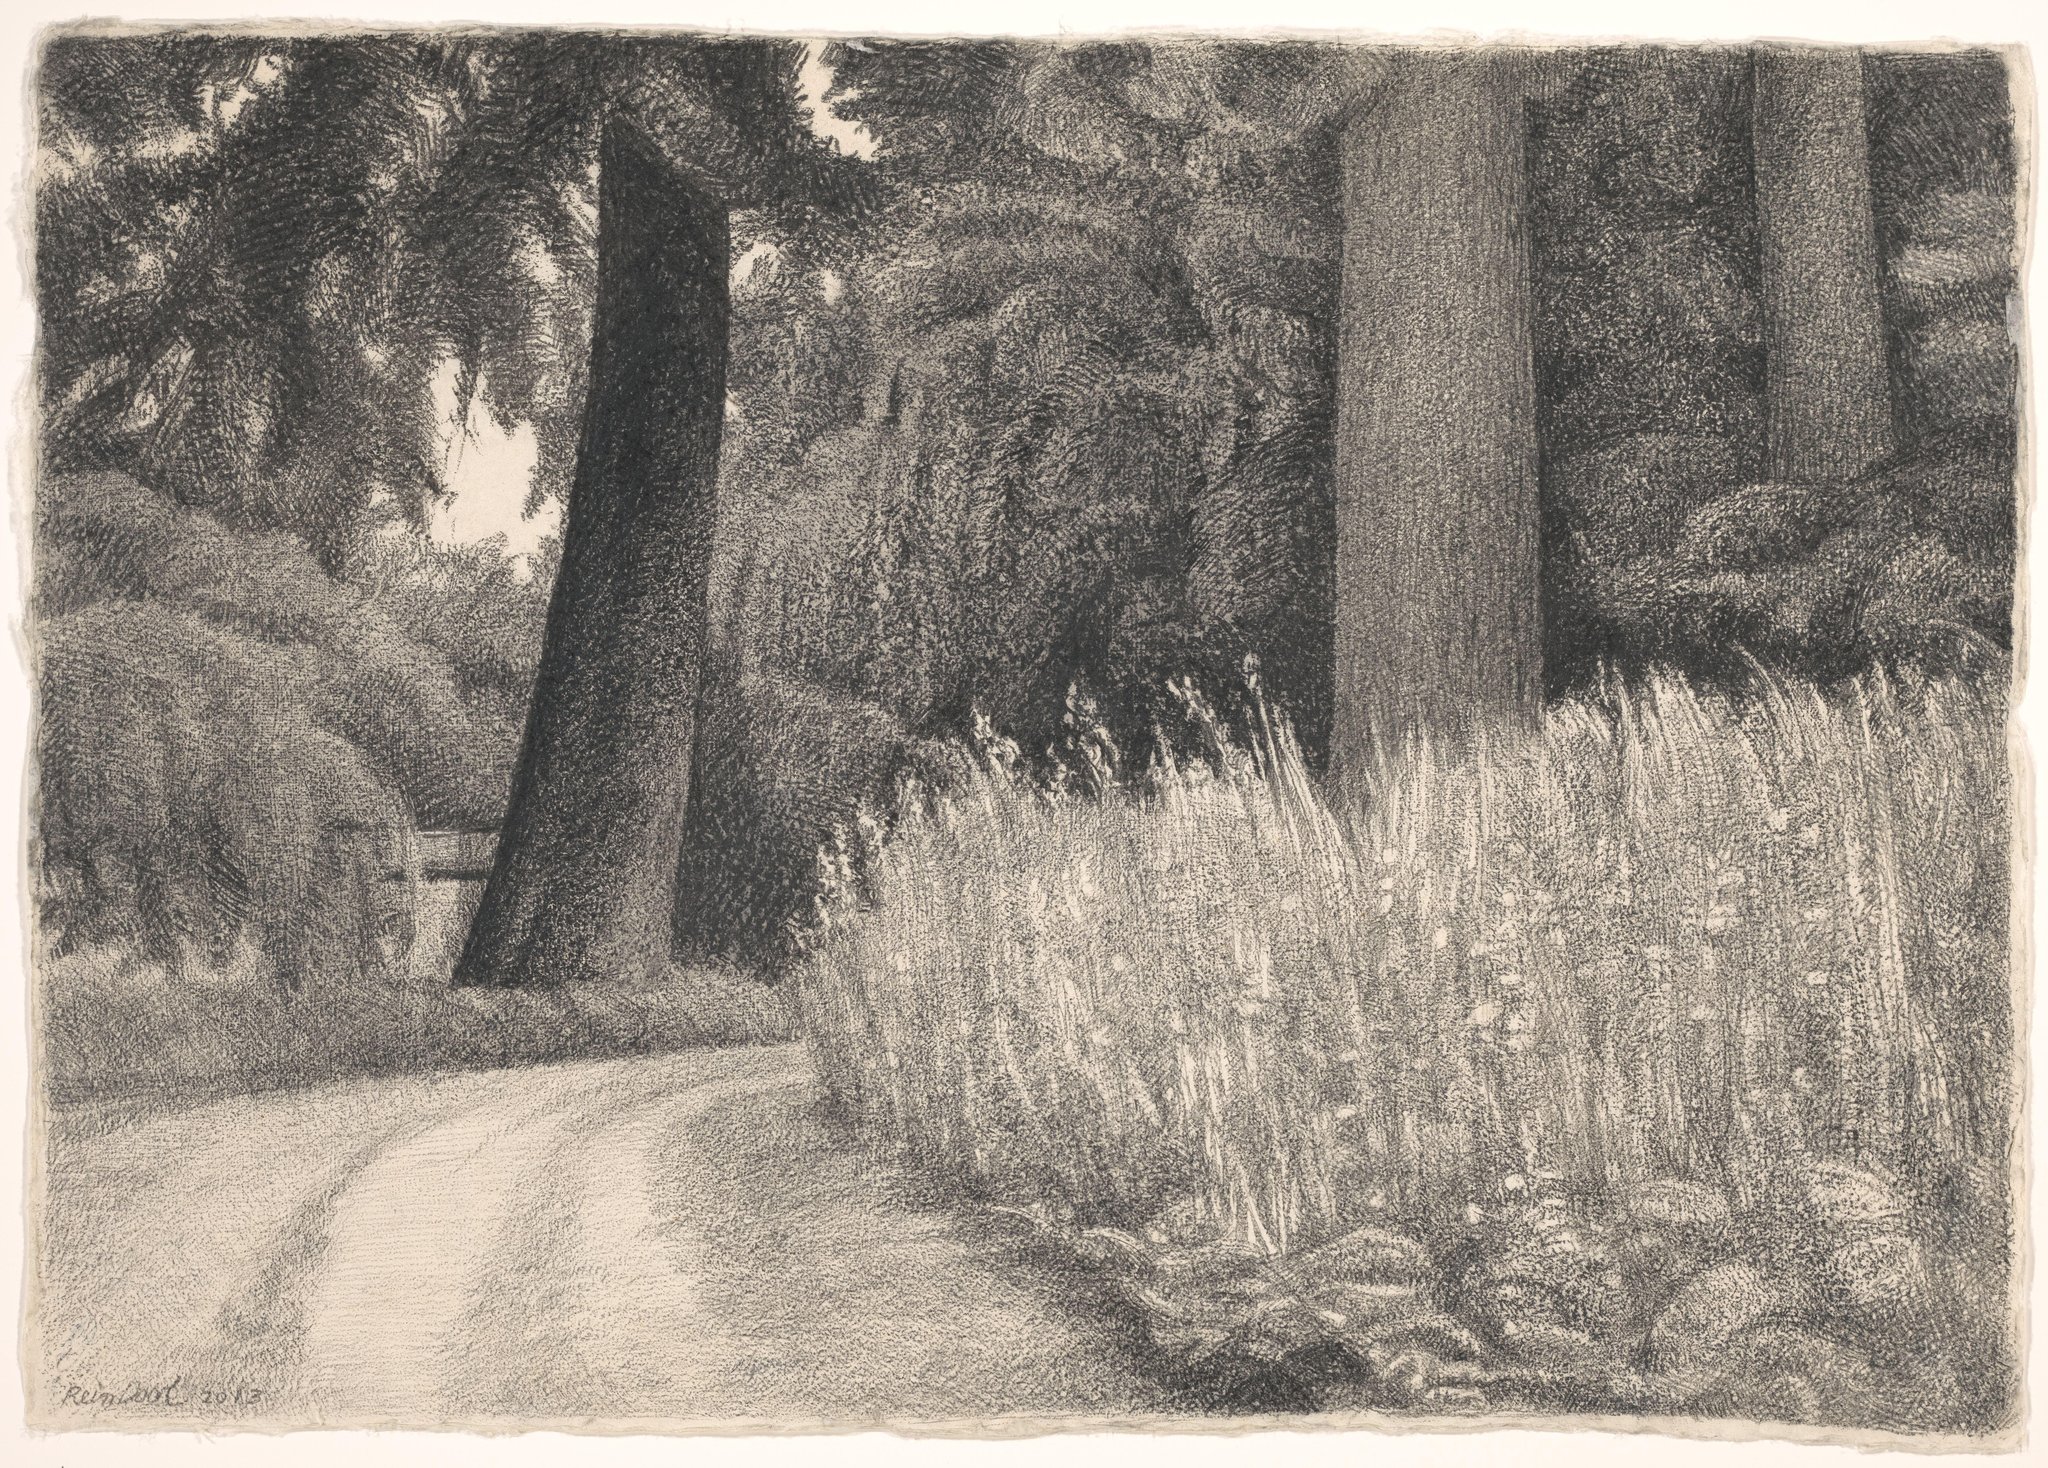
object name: drawing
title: Wandelpad in Dordtwijk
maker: rein dool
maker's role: draughtsman, painter, print maker, sculptor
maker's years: 1933-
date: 2013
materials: charcoal, paper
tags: dordrecht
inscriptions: signature and date